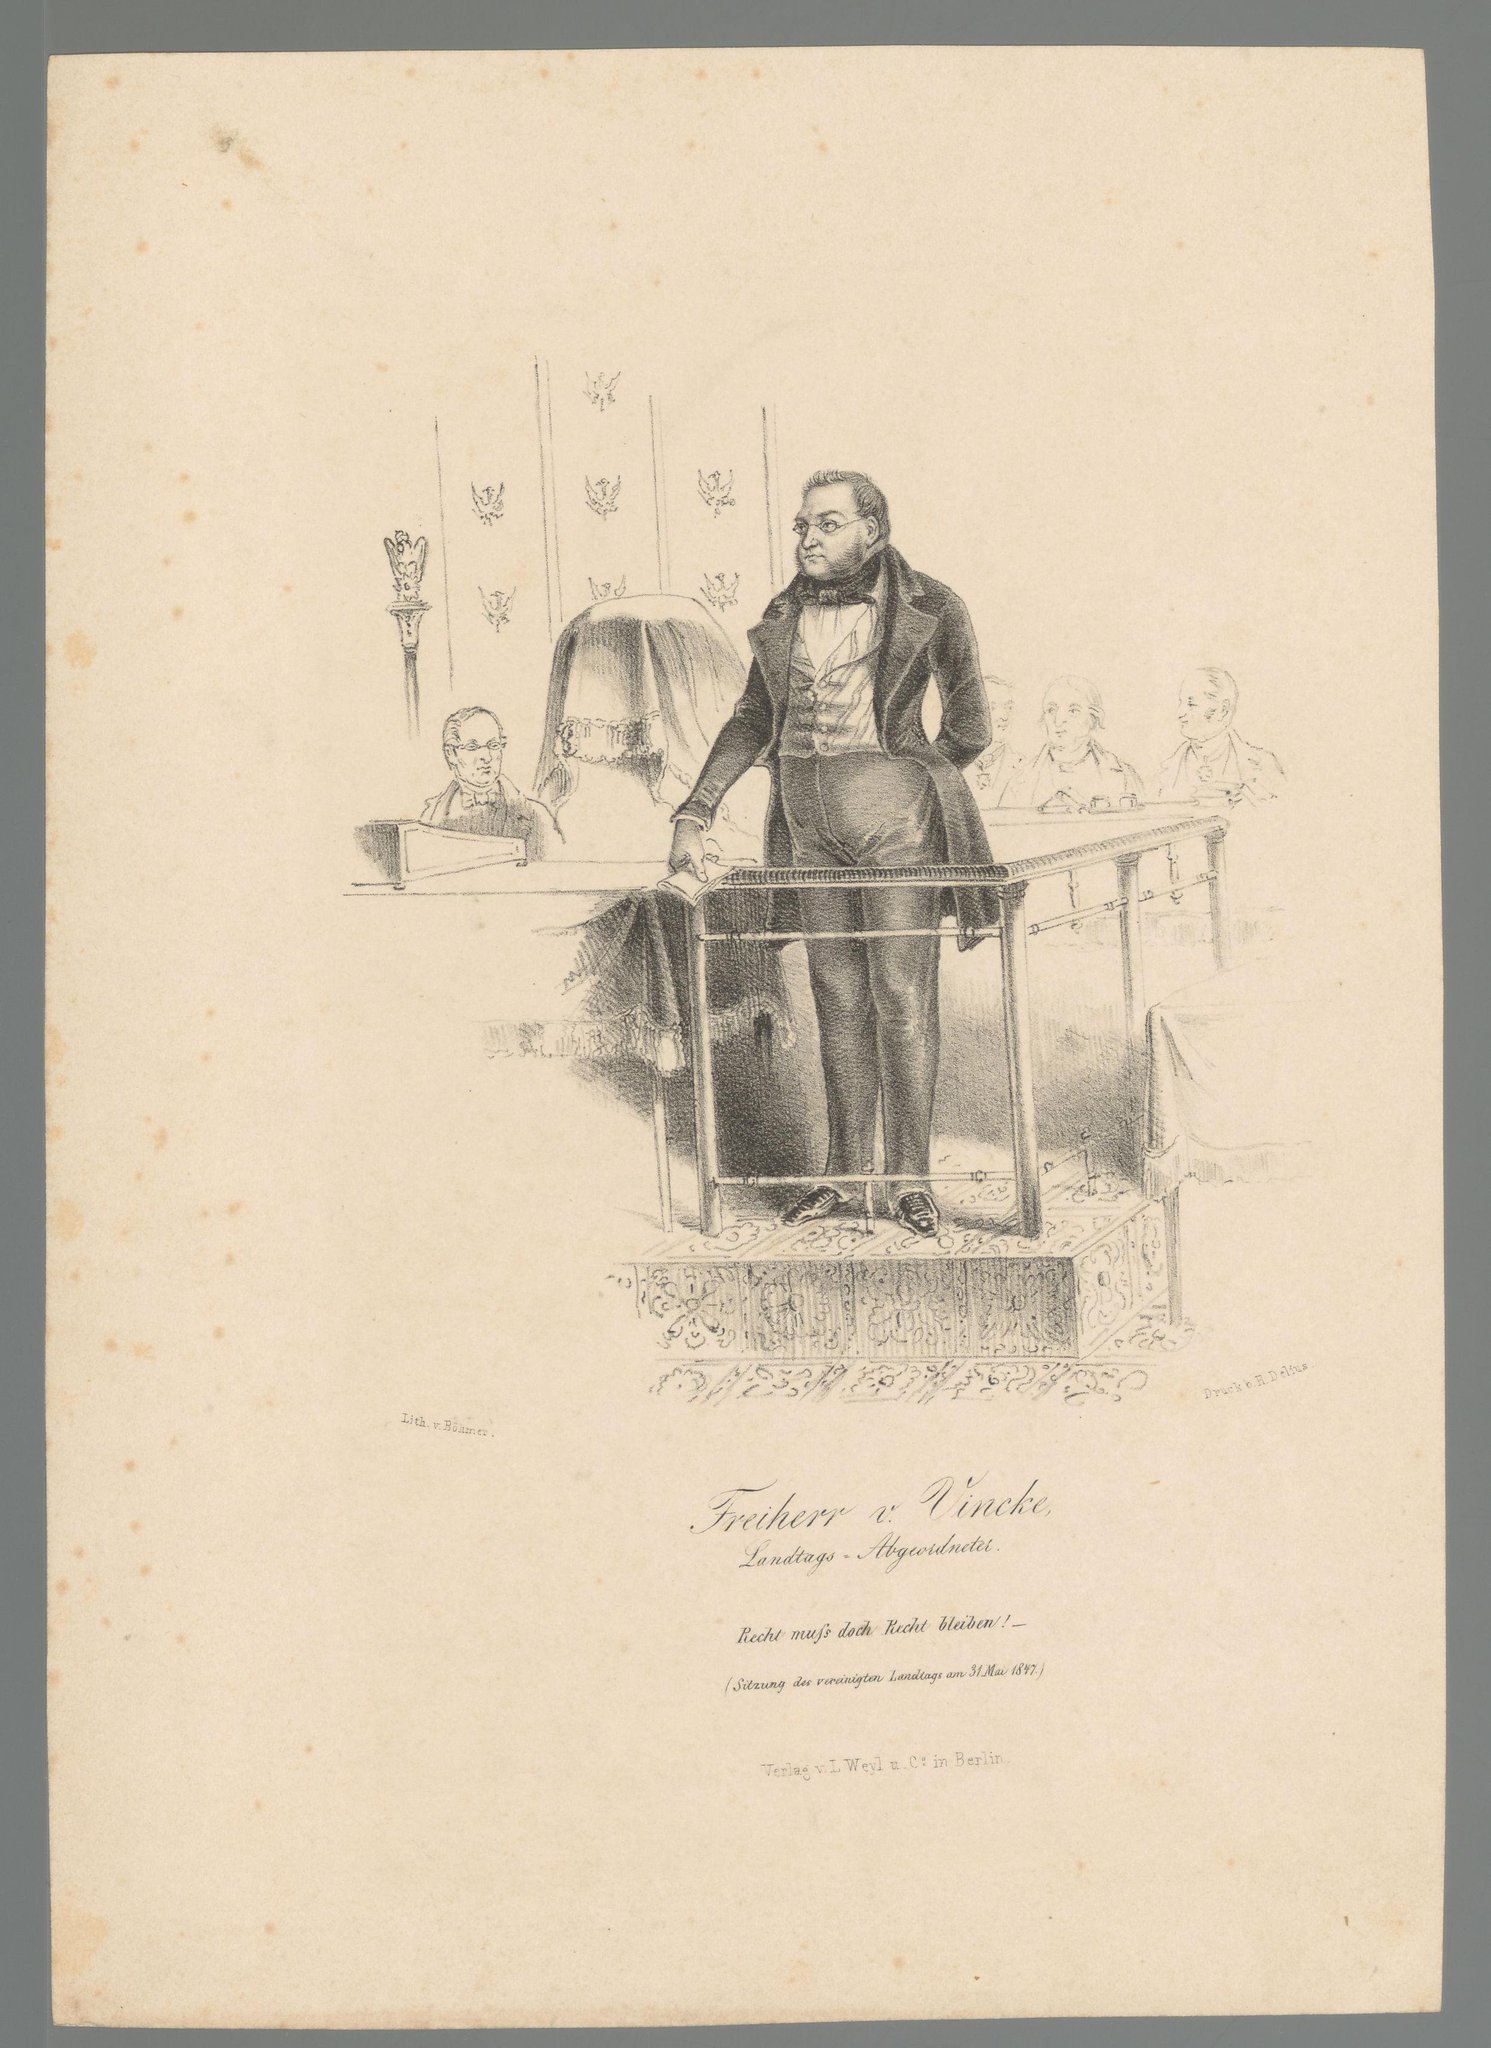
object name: print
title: Georg von Vincke spreekt bij het staatsparlement op 31 mei 1847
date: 1847-1850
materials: paper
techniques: lithograph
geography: berlin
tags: adult man, historical persons, state; law; political life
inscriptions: collector's mark: Lugt 2228